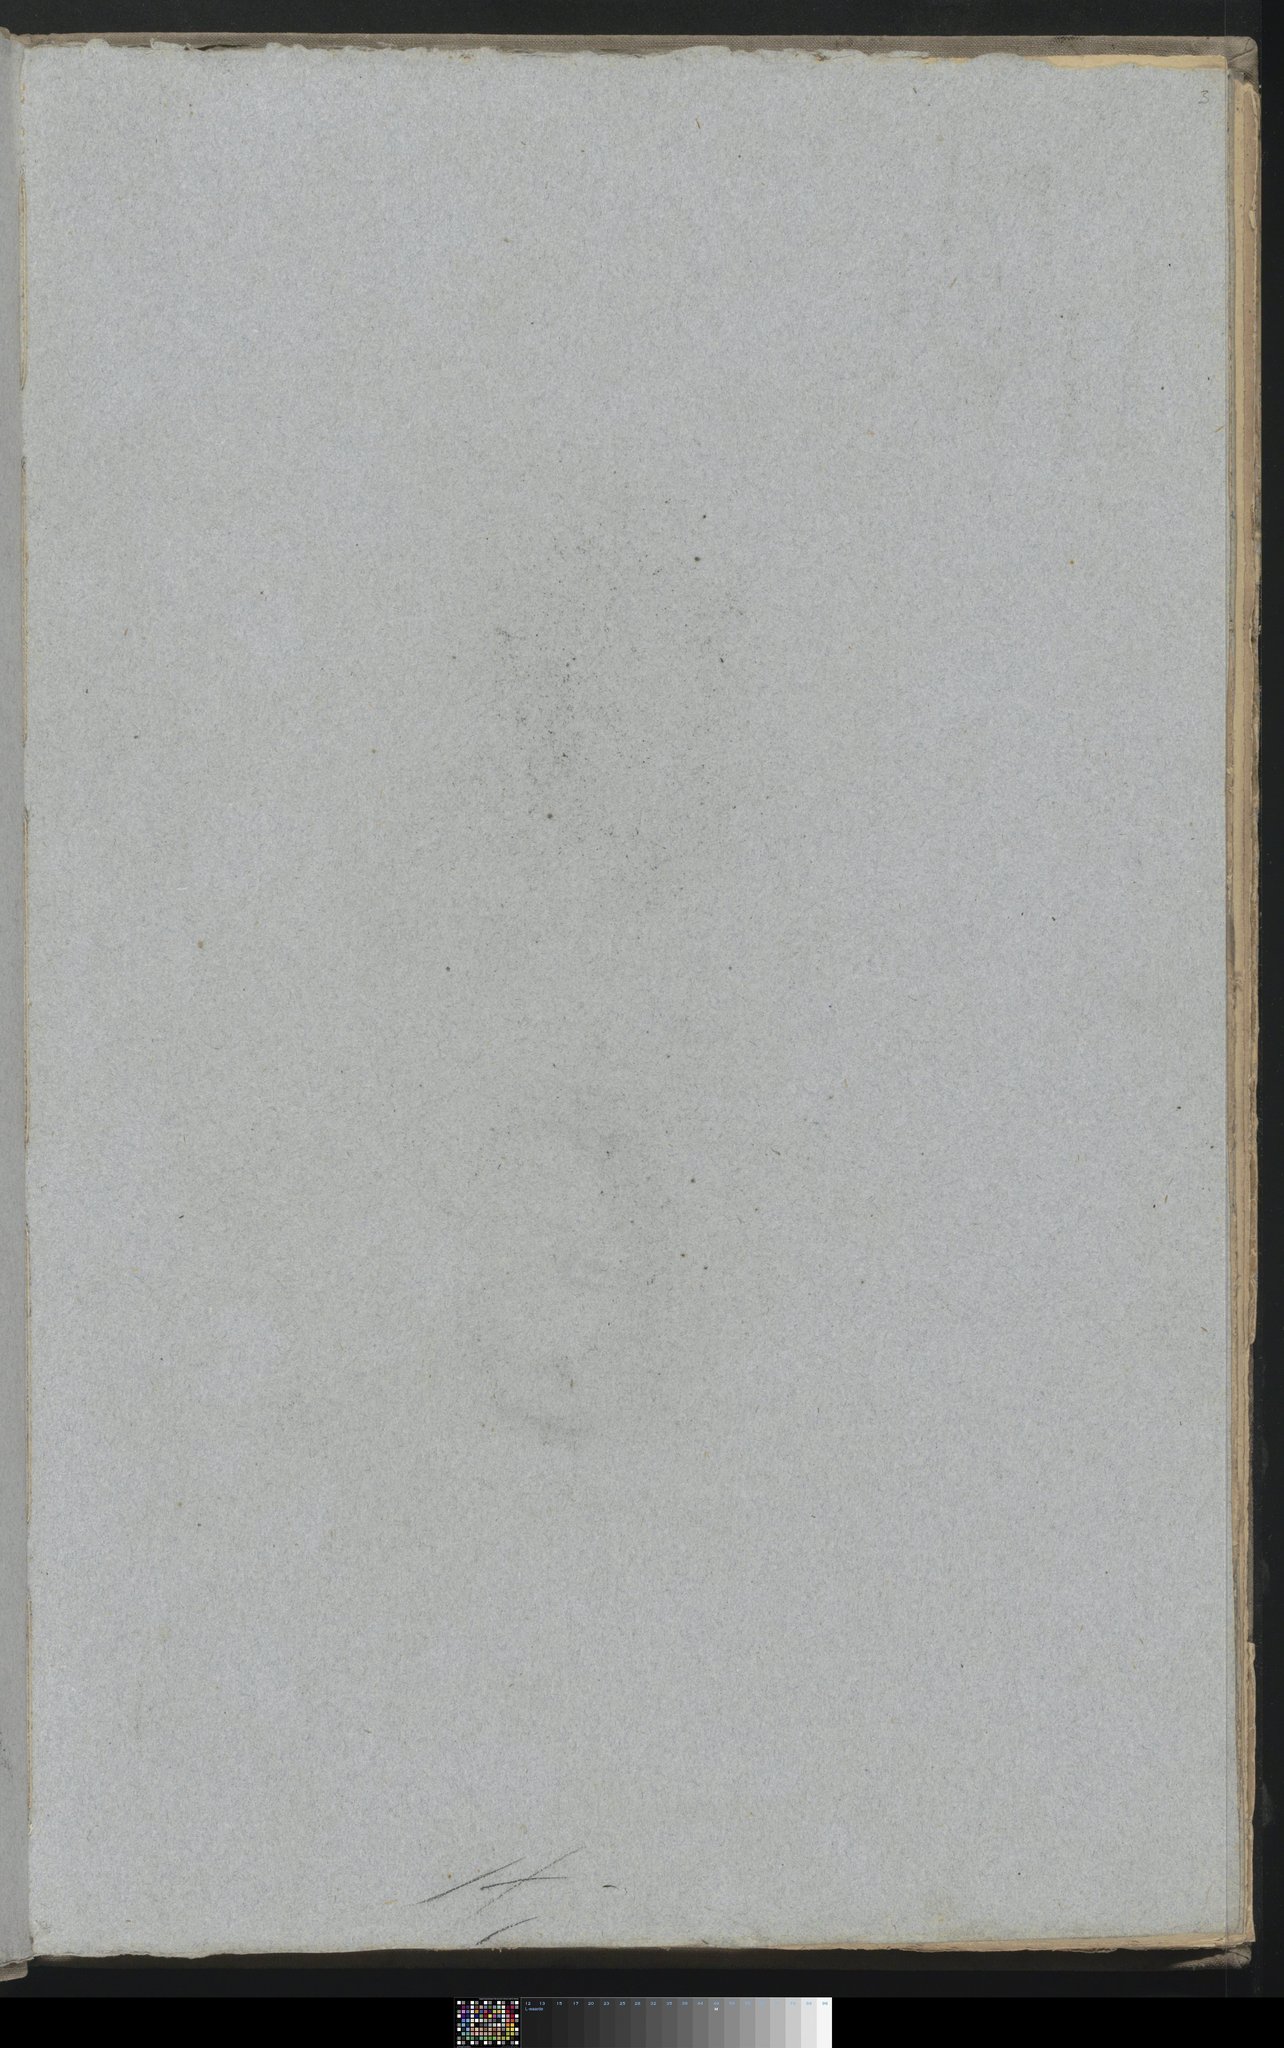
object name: sketchbook leaf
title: Abklatsch van een krijttekening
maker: willem witsen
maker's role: draughtsman, painter, print maker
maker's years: 1860-1923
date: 1886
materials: paper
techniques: printmaking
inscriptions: annotation: ‘[...]’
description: Pagina 3 uit een schetsboek met 38 bladen betekend rond de Ewijkshoeve.